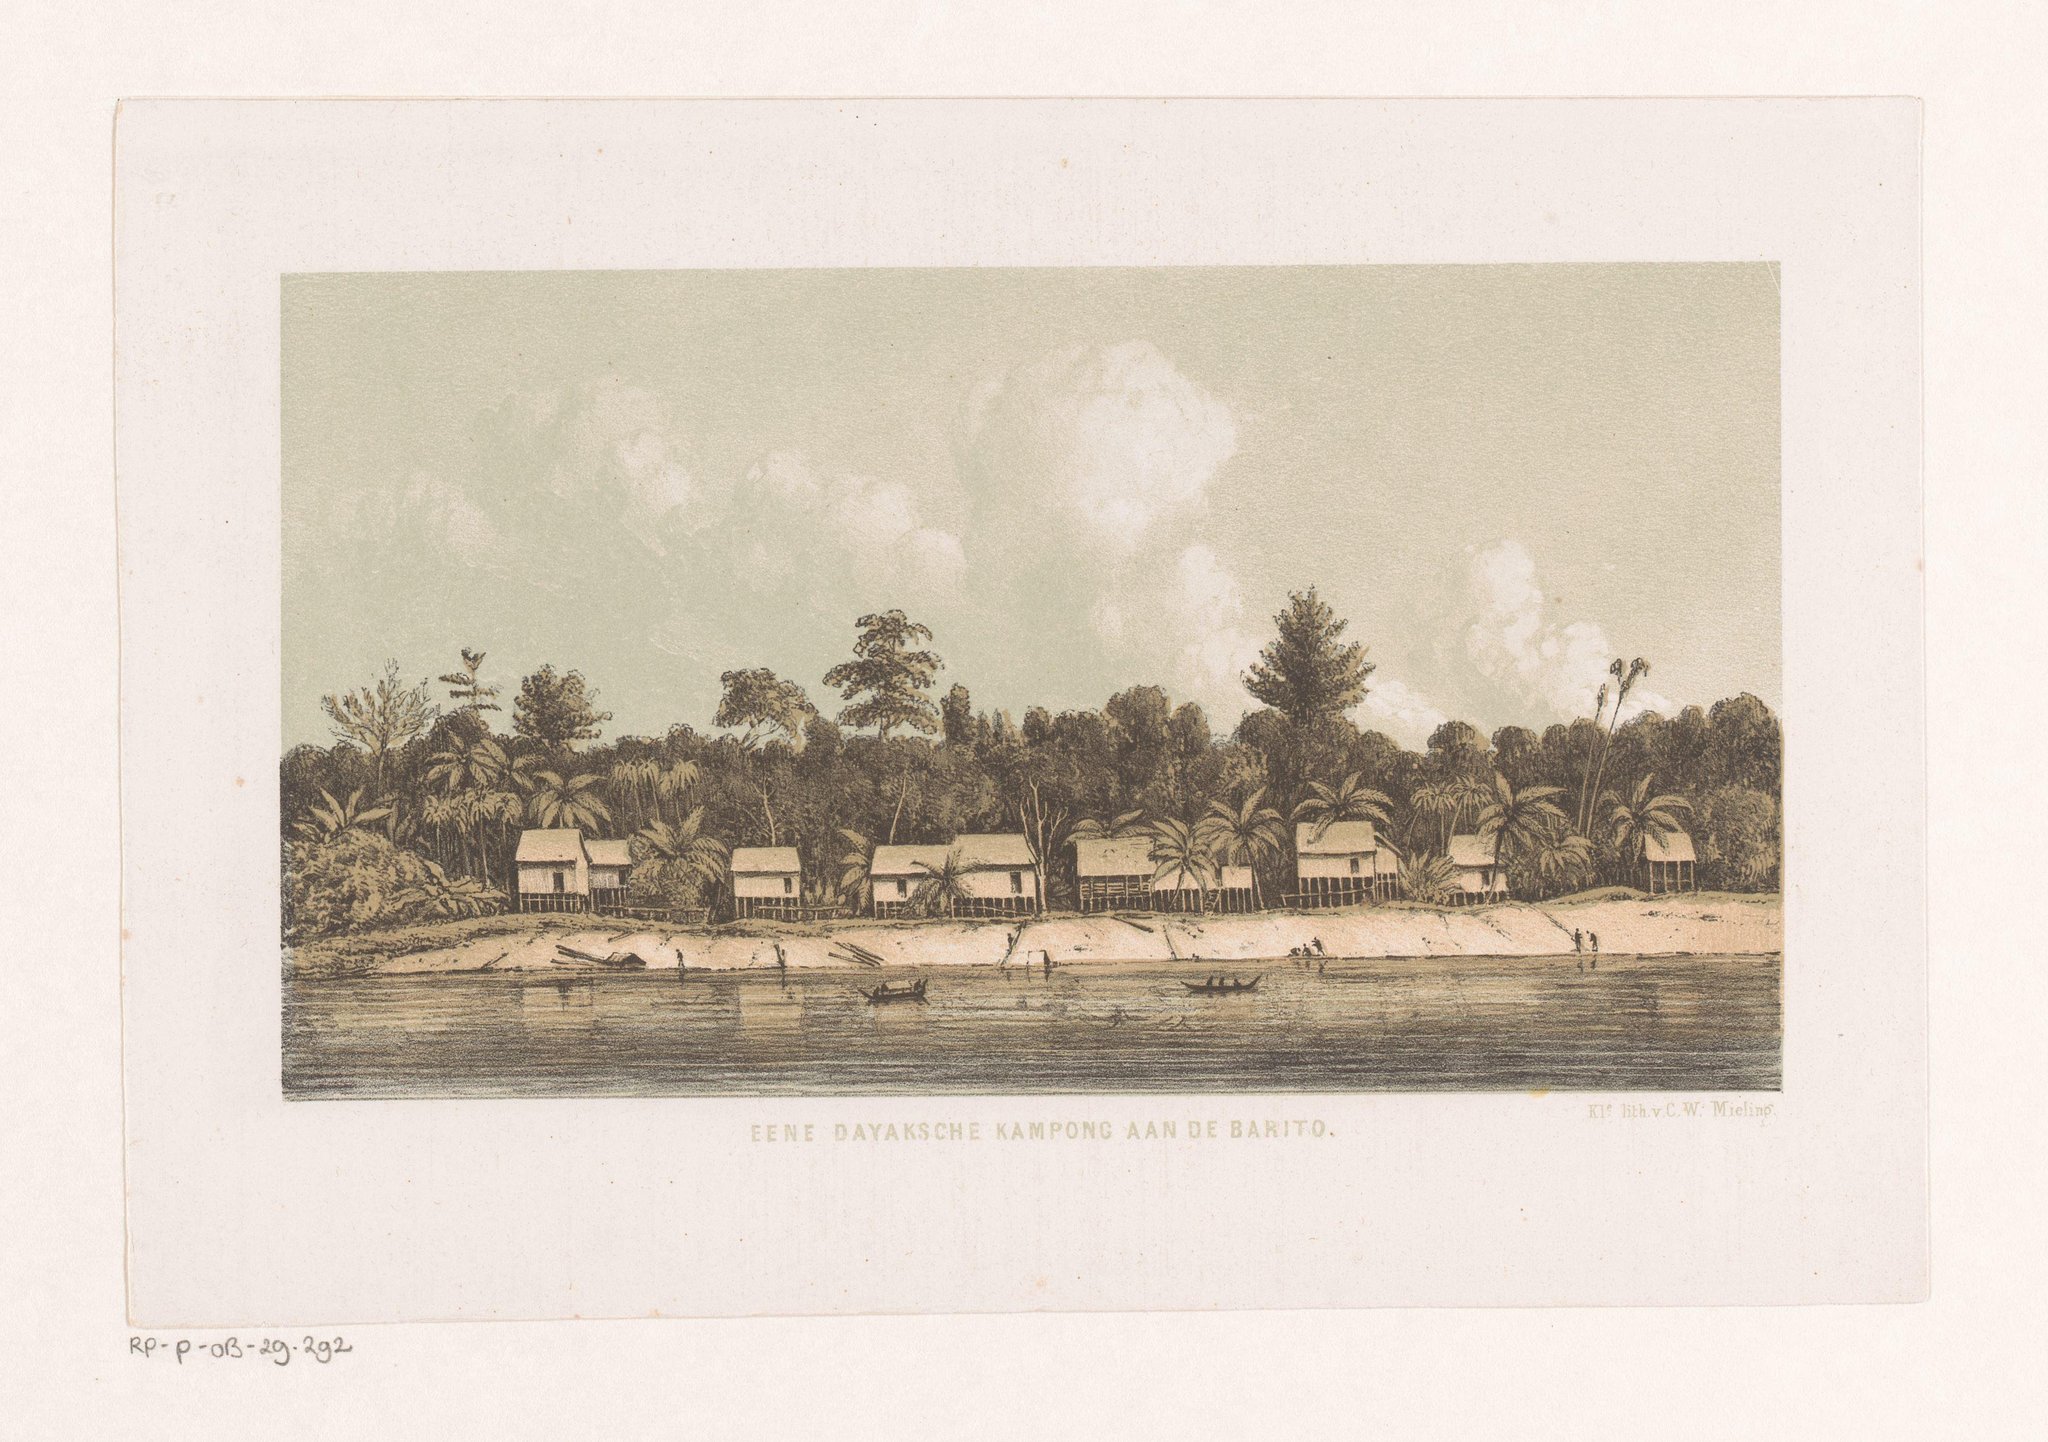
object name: print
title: Eene Dayaksche kampong aan de Barito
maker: Anonymous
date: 1853-1854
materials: paper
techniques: tone lithography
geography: the hague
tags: imperialism, village, river (+ landscape with figures, staffage)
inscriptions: collector's mark: Lugt 2228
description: Gepubliceerd in: C. A. L. M. Schwaner, Borneo: Beschrijving van het stroomgebied van den Barito en reizen langs eenige voorname rivieren van het zuid-oostelijk gedeelte van dat eiland, door Dr. C.A.L.M. Schwaner op last van het Gouvernement van Nederl. Indië gedaan in de jaren 1843-1847. Amsterdam, P.N. Van Kampen: 1853-1854.